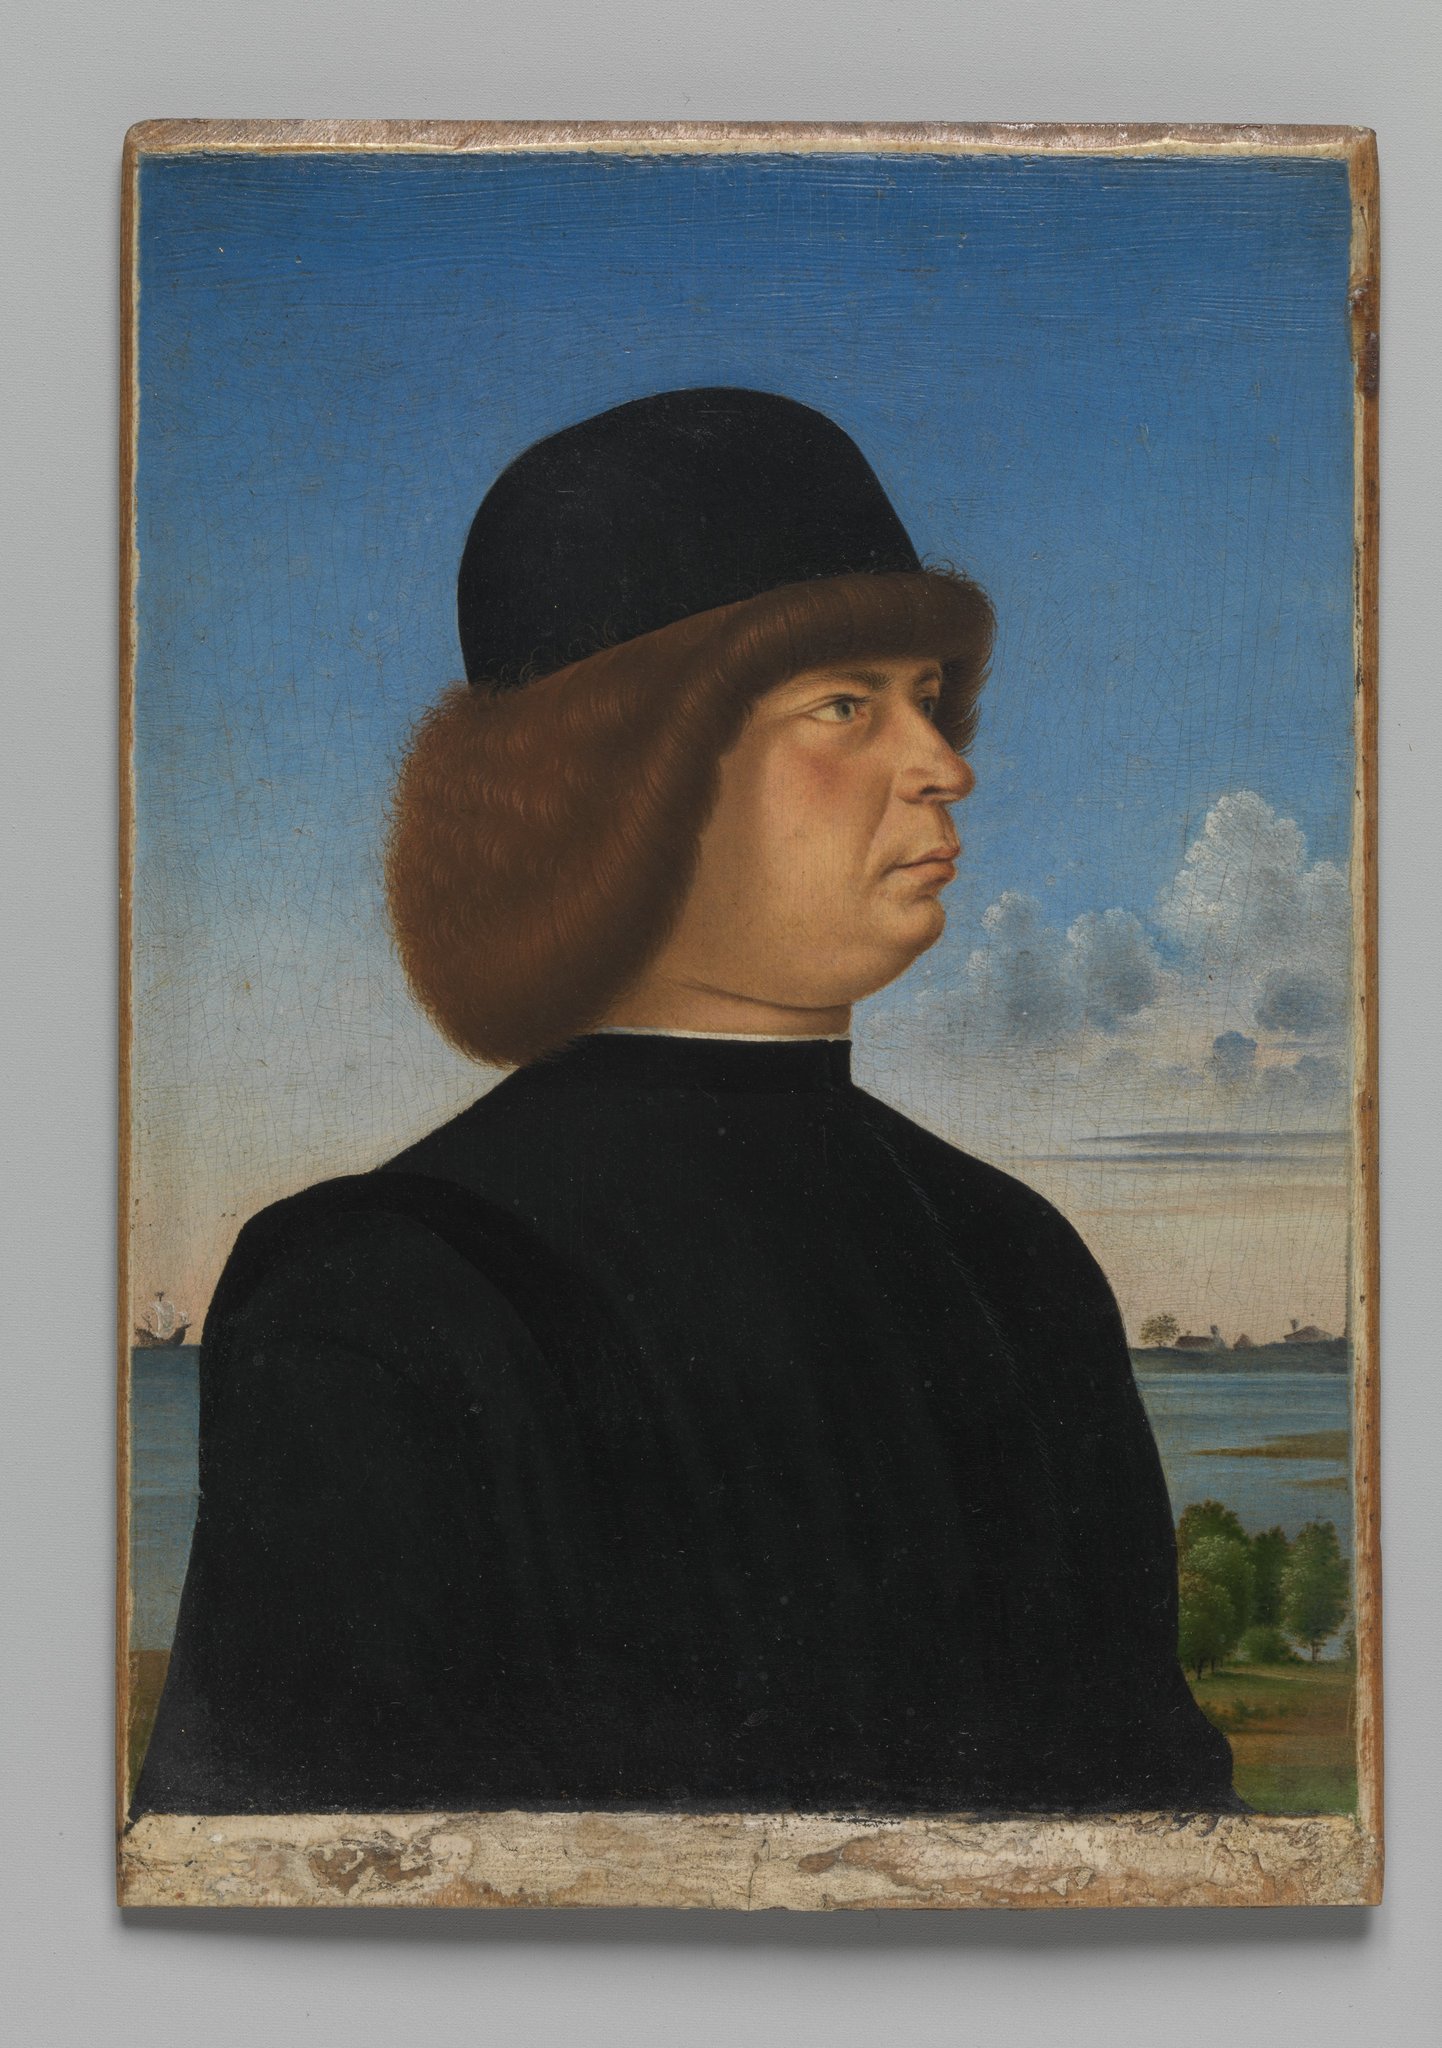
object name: painting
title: Portrait of Alvise Contarini(?); (verso) A Tethered Roebuck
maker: jacometto (jacometto veneziano)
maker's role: artist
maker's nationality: italian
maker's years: 1472-1498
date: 1485-1495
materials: gold, oil, wood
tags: men,portraits,profiles